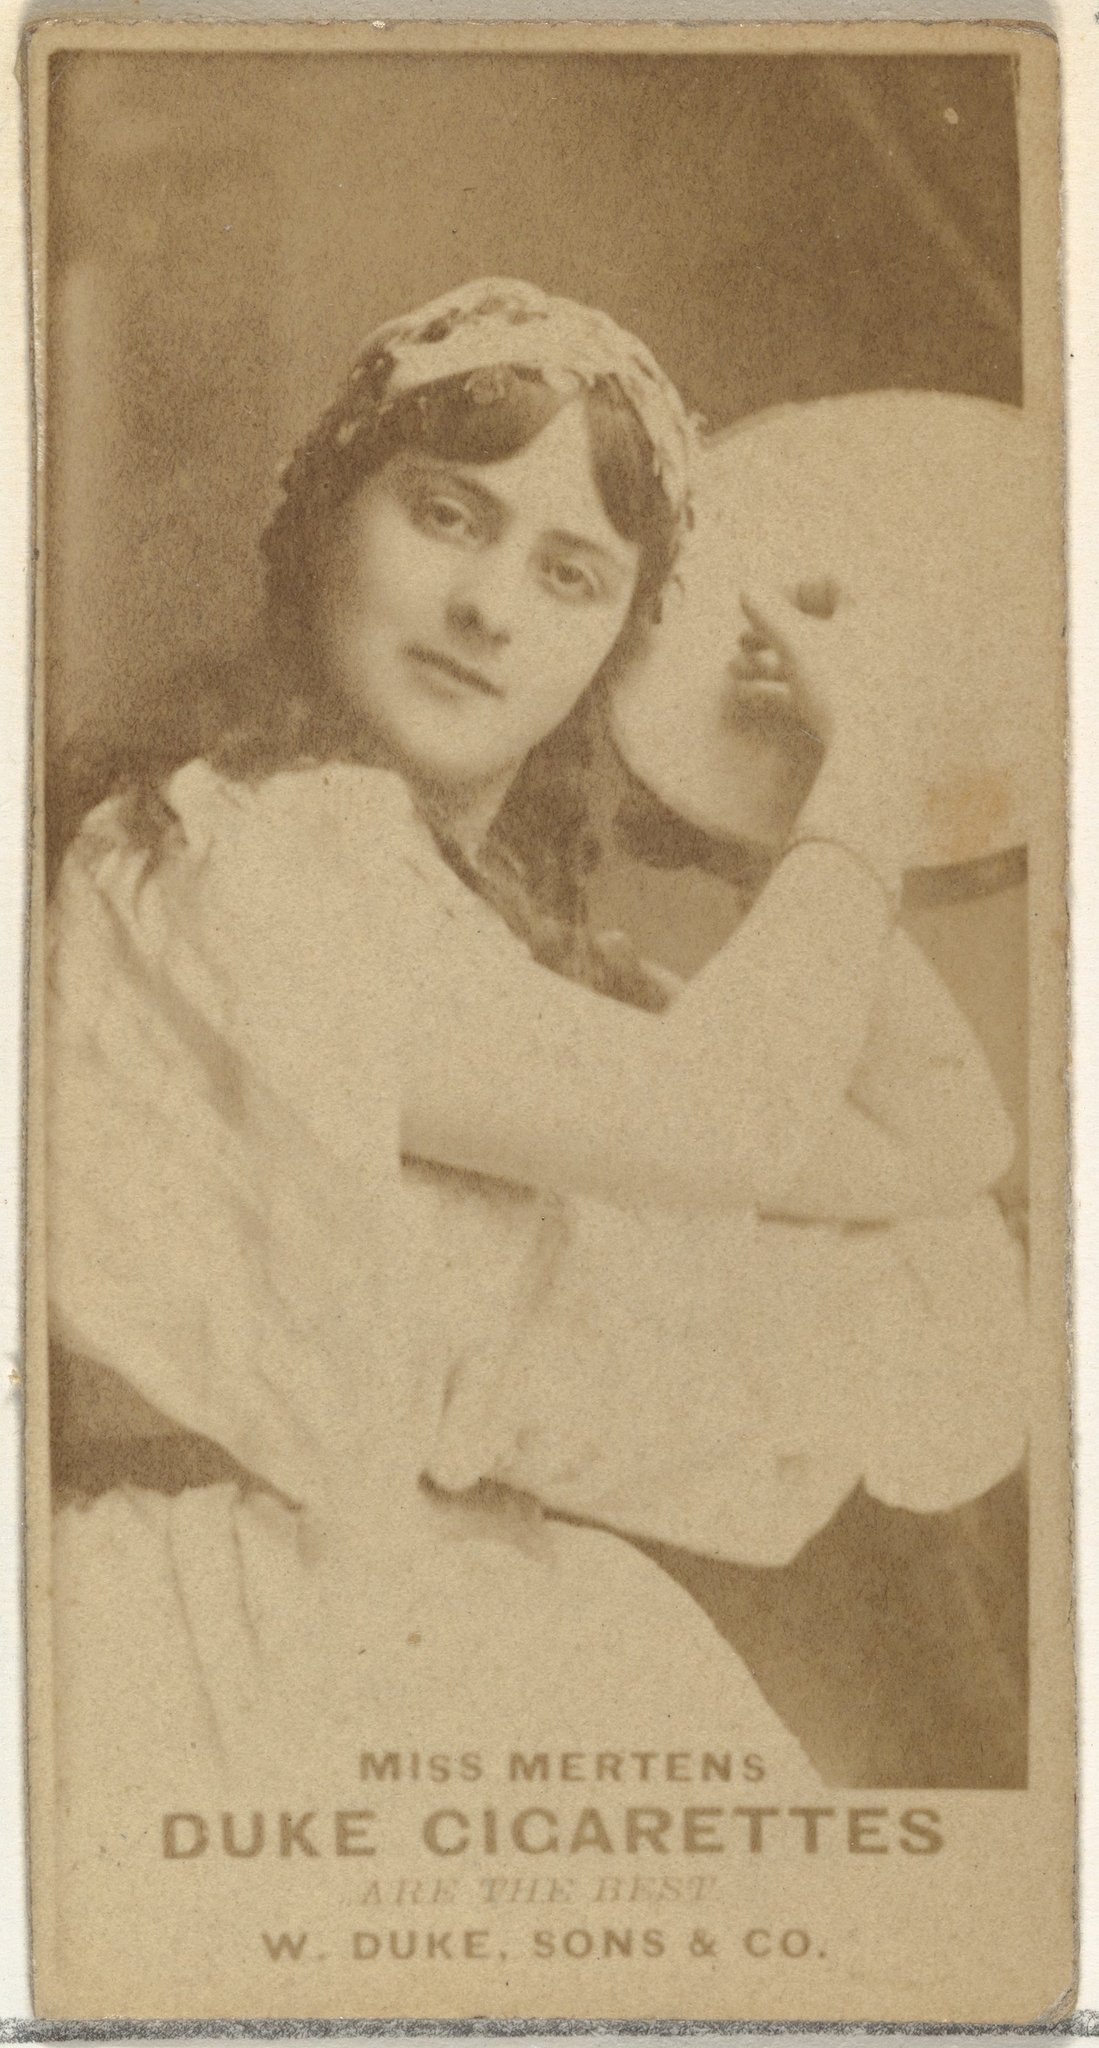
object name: photograph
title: Miss Mertens, from the Actors and Actresses series (N145-7) issued by Duke Sons & Co. to promote Duke Cigarettes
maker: w. duke, sons & co.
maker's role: publisher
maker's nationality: american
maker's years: 1870-1920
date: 1880-1889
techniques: albumen silver print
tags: portraits,women,actresses